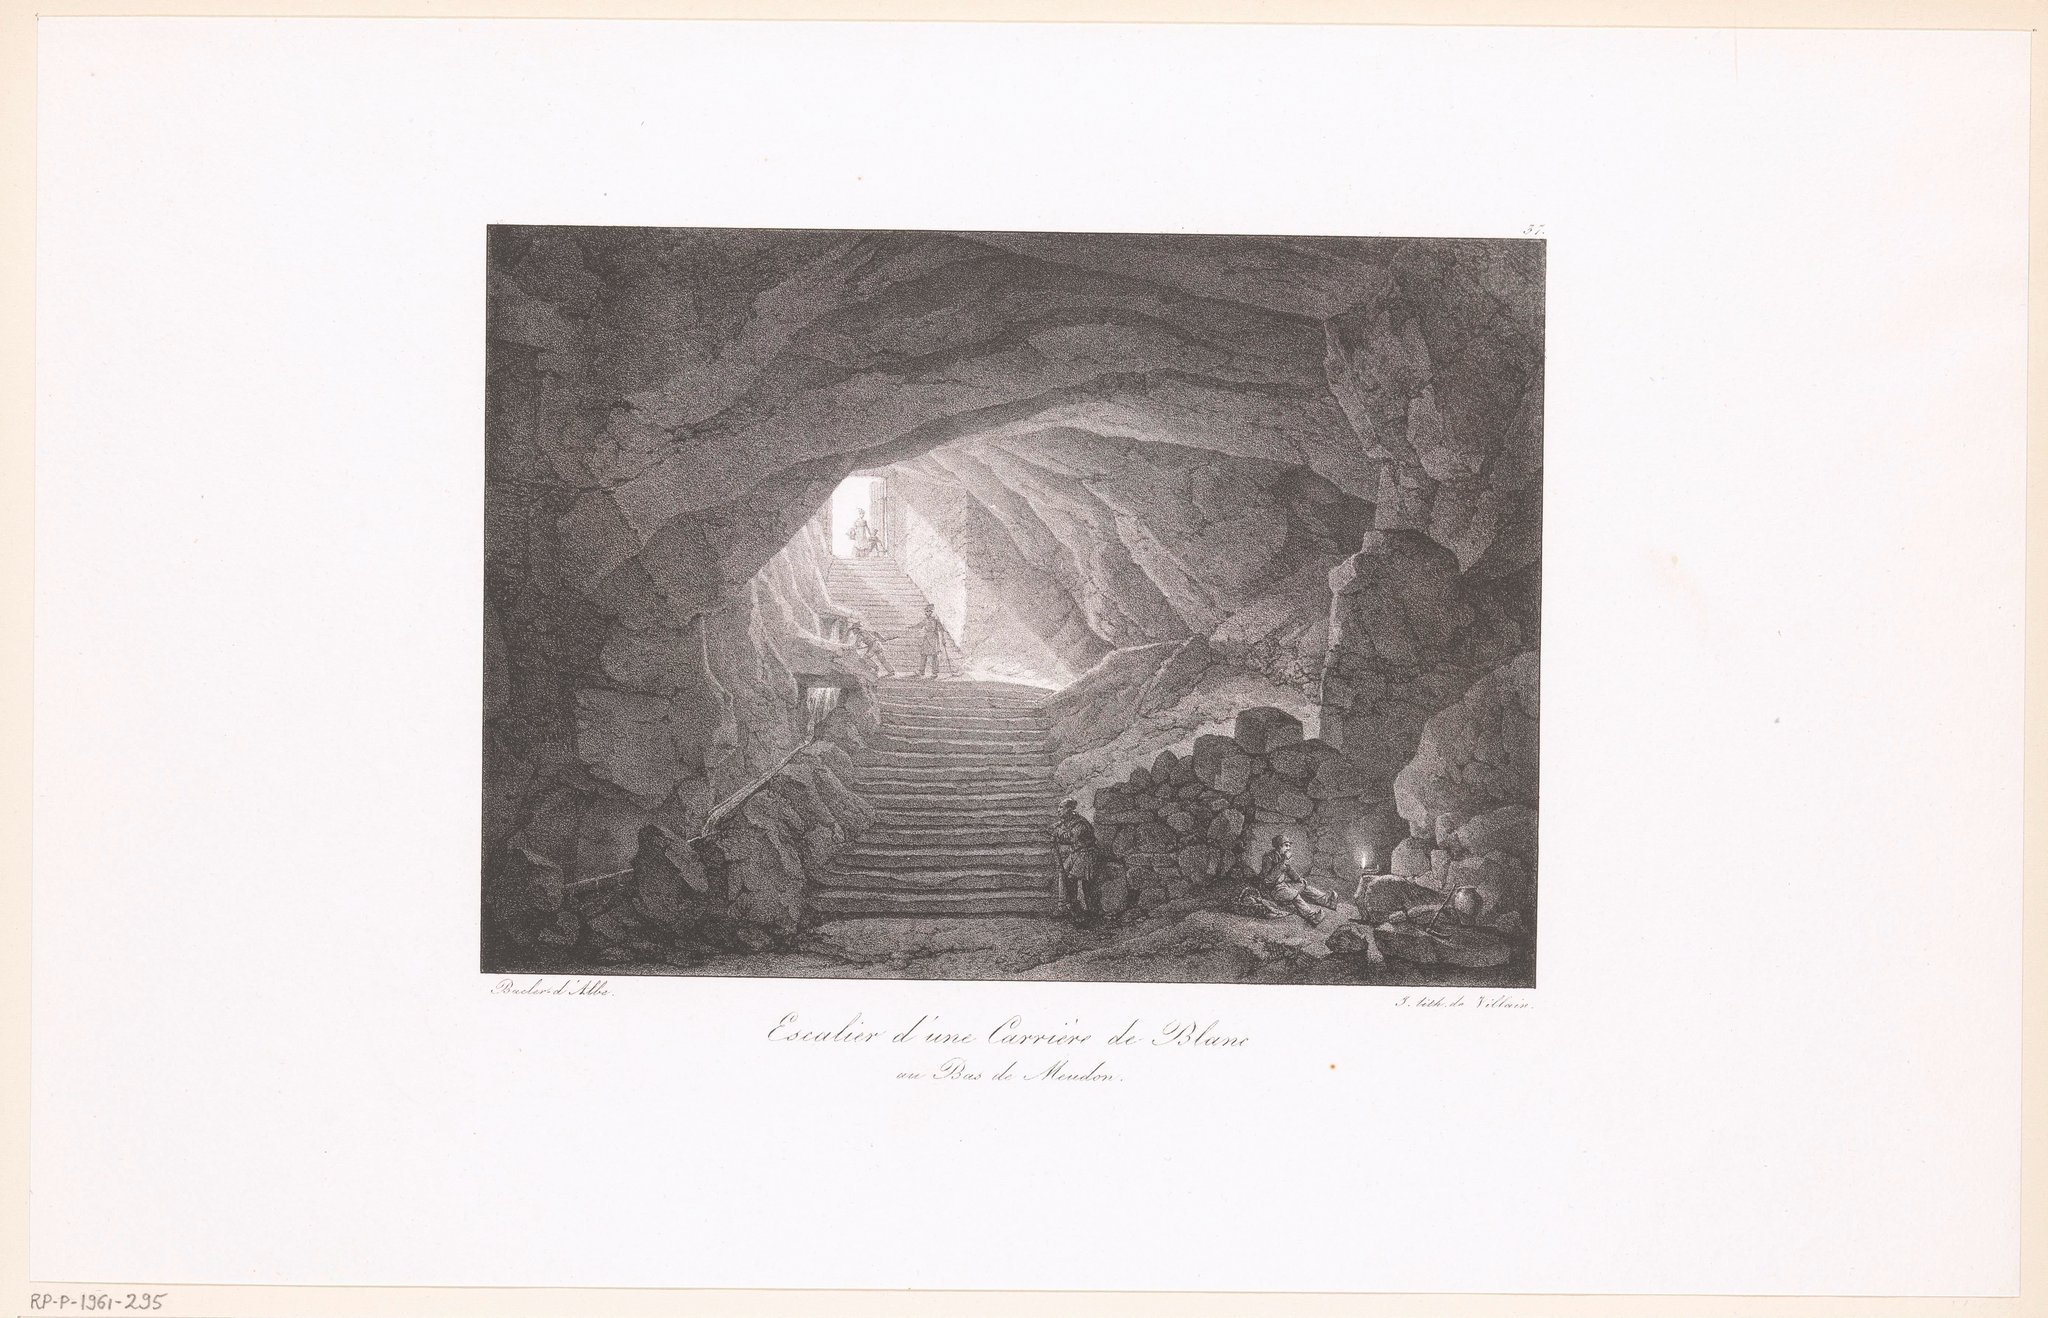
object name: print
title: Escalier d'une carrière de Blanc au Bas de Meudon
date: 1822-1824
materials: paper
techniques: lithograph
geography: paris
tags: kinds of non-precious stone: chalk, miner, industries ~ clay, sand, chalk, etc., quarry, staircase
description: Onder aan de trap rusten twee mijnwerkers uit.